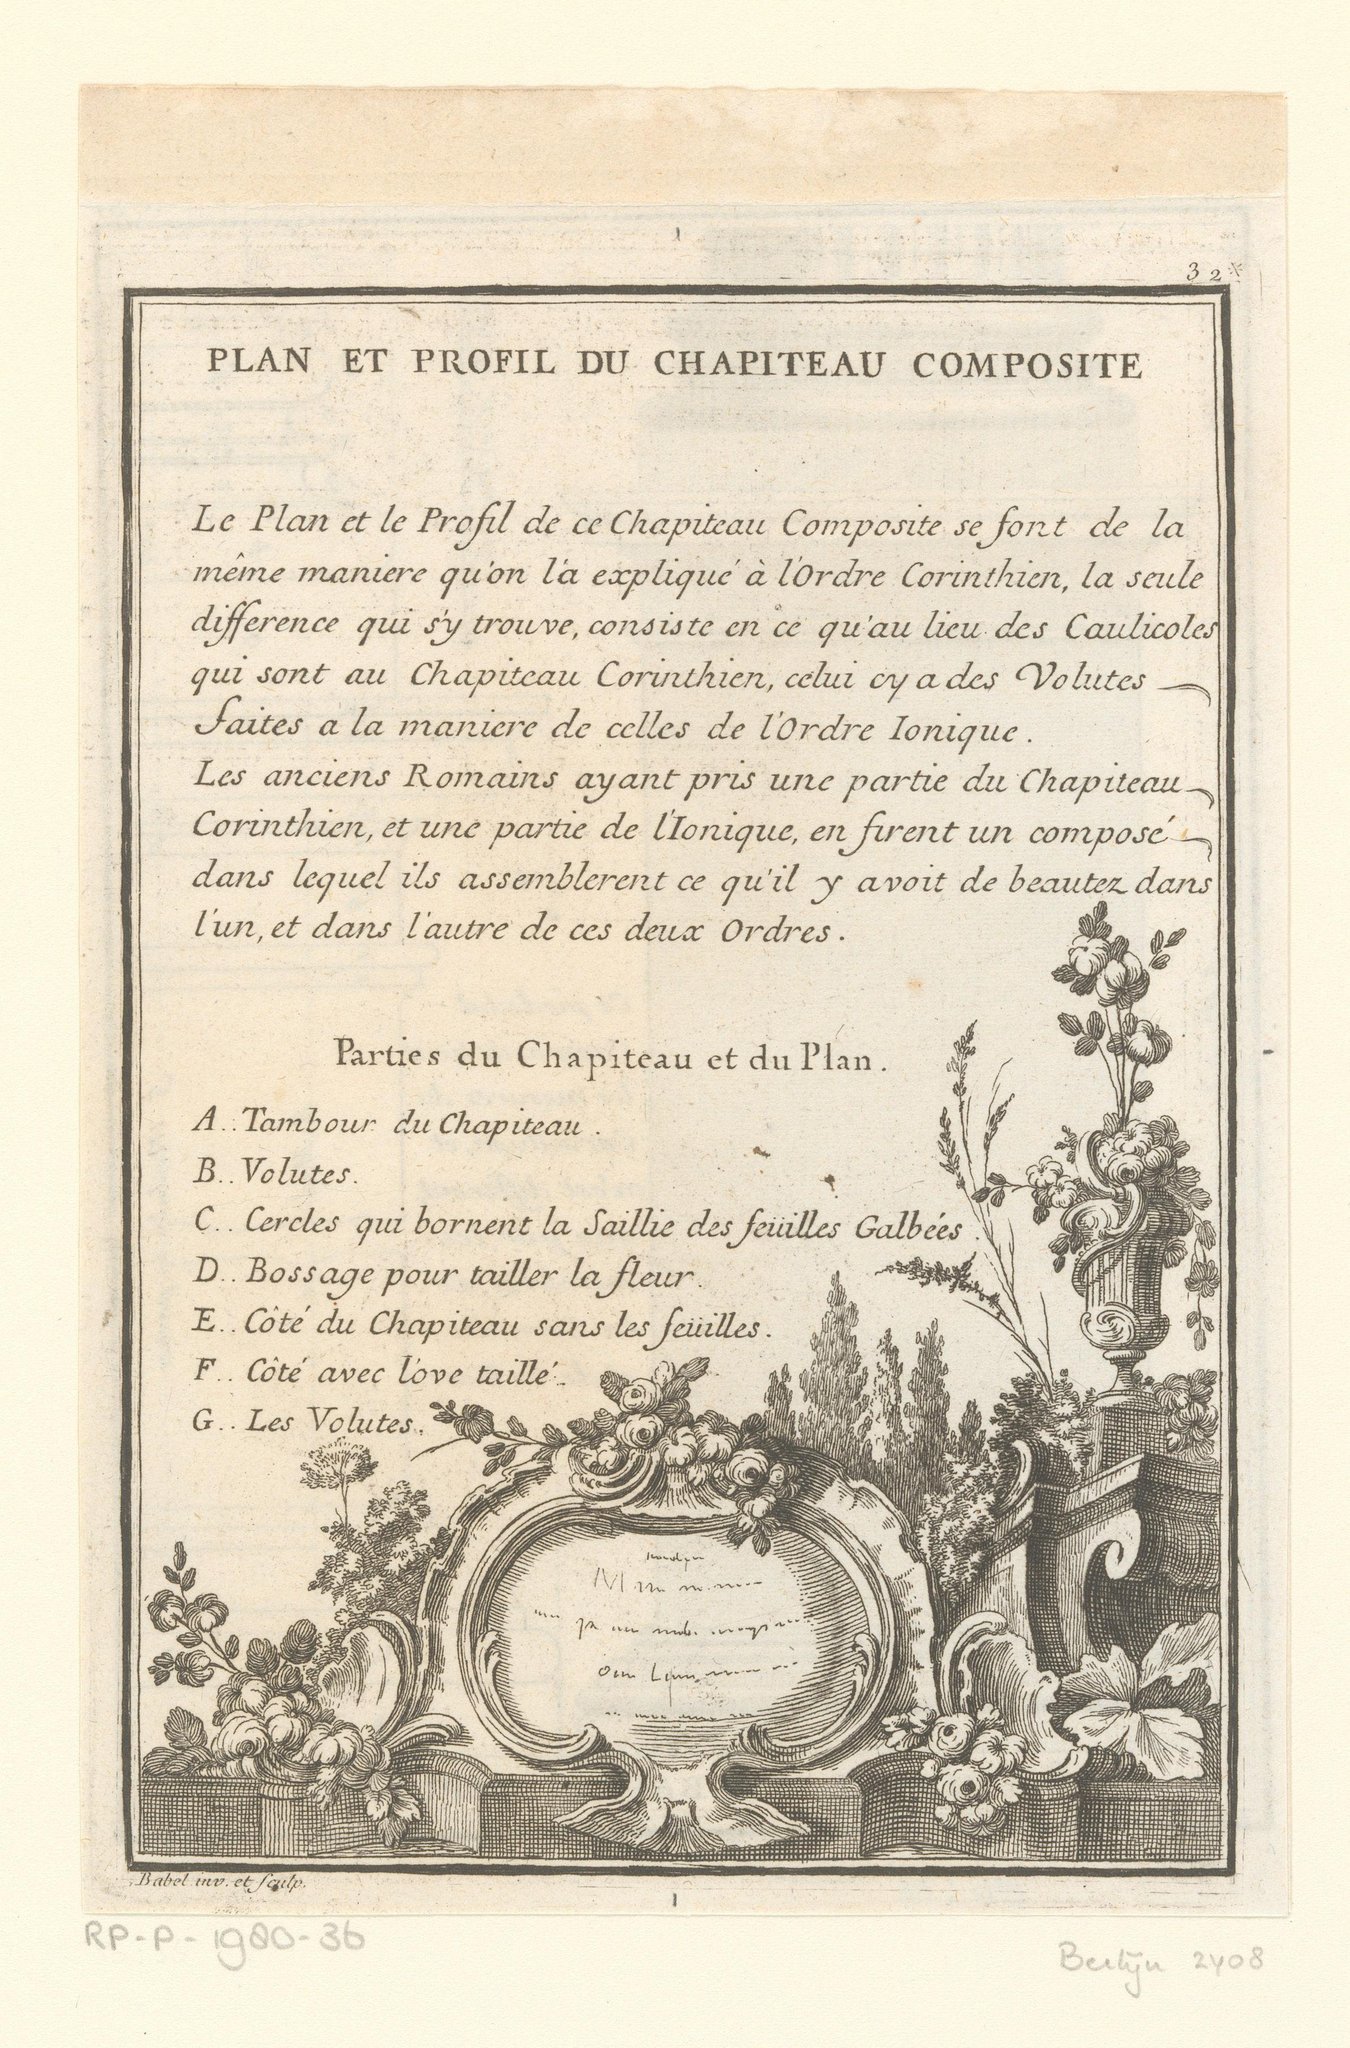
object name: ornament print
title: Rocaille cartouche in landschap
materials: paper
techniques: etching, letterpress printing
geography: paris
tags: ornament ~ cartouche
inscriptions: collector's mark: Lugt 2228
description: Pagina 32 uit: Babel, Pierre Edme. Le Nouveau Vignole ou Regles Des Cinq Ordres D'Architecture (...). Parijs: Chereau, François (II), 1755.